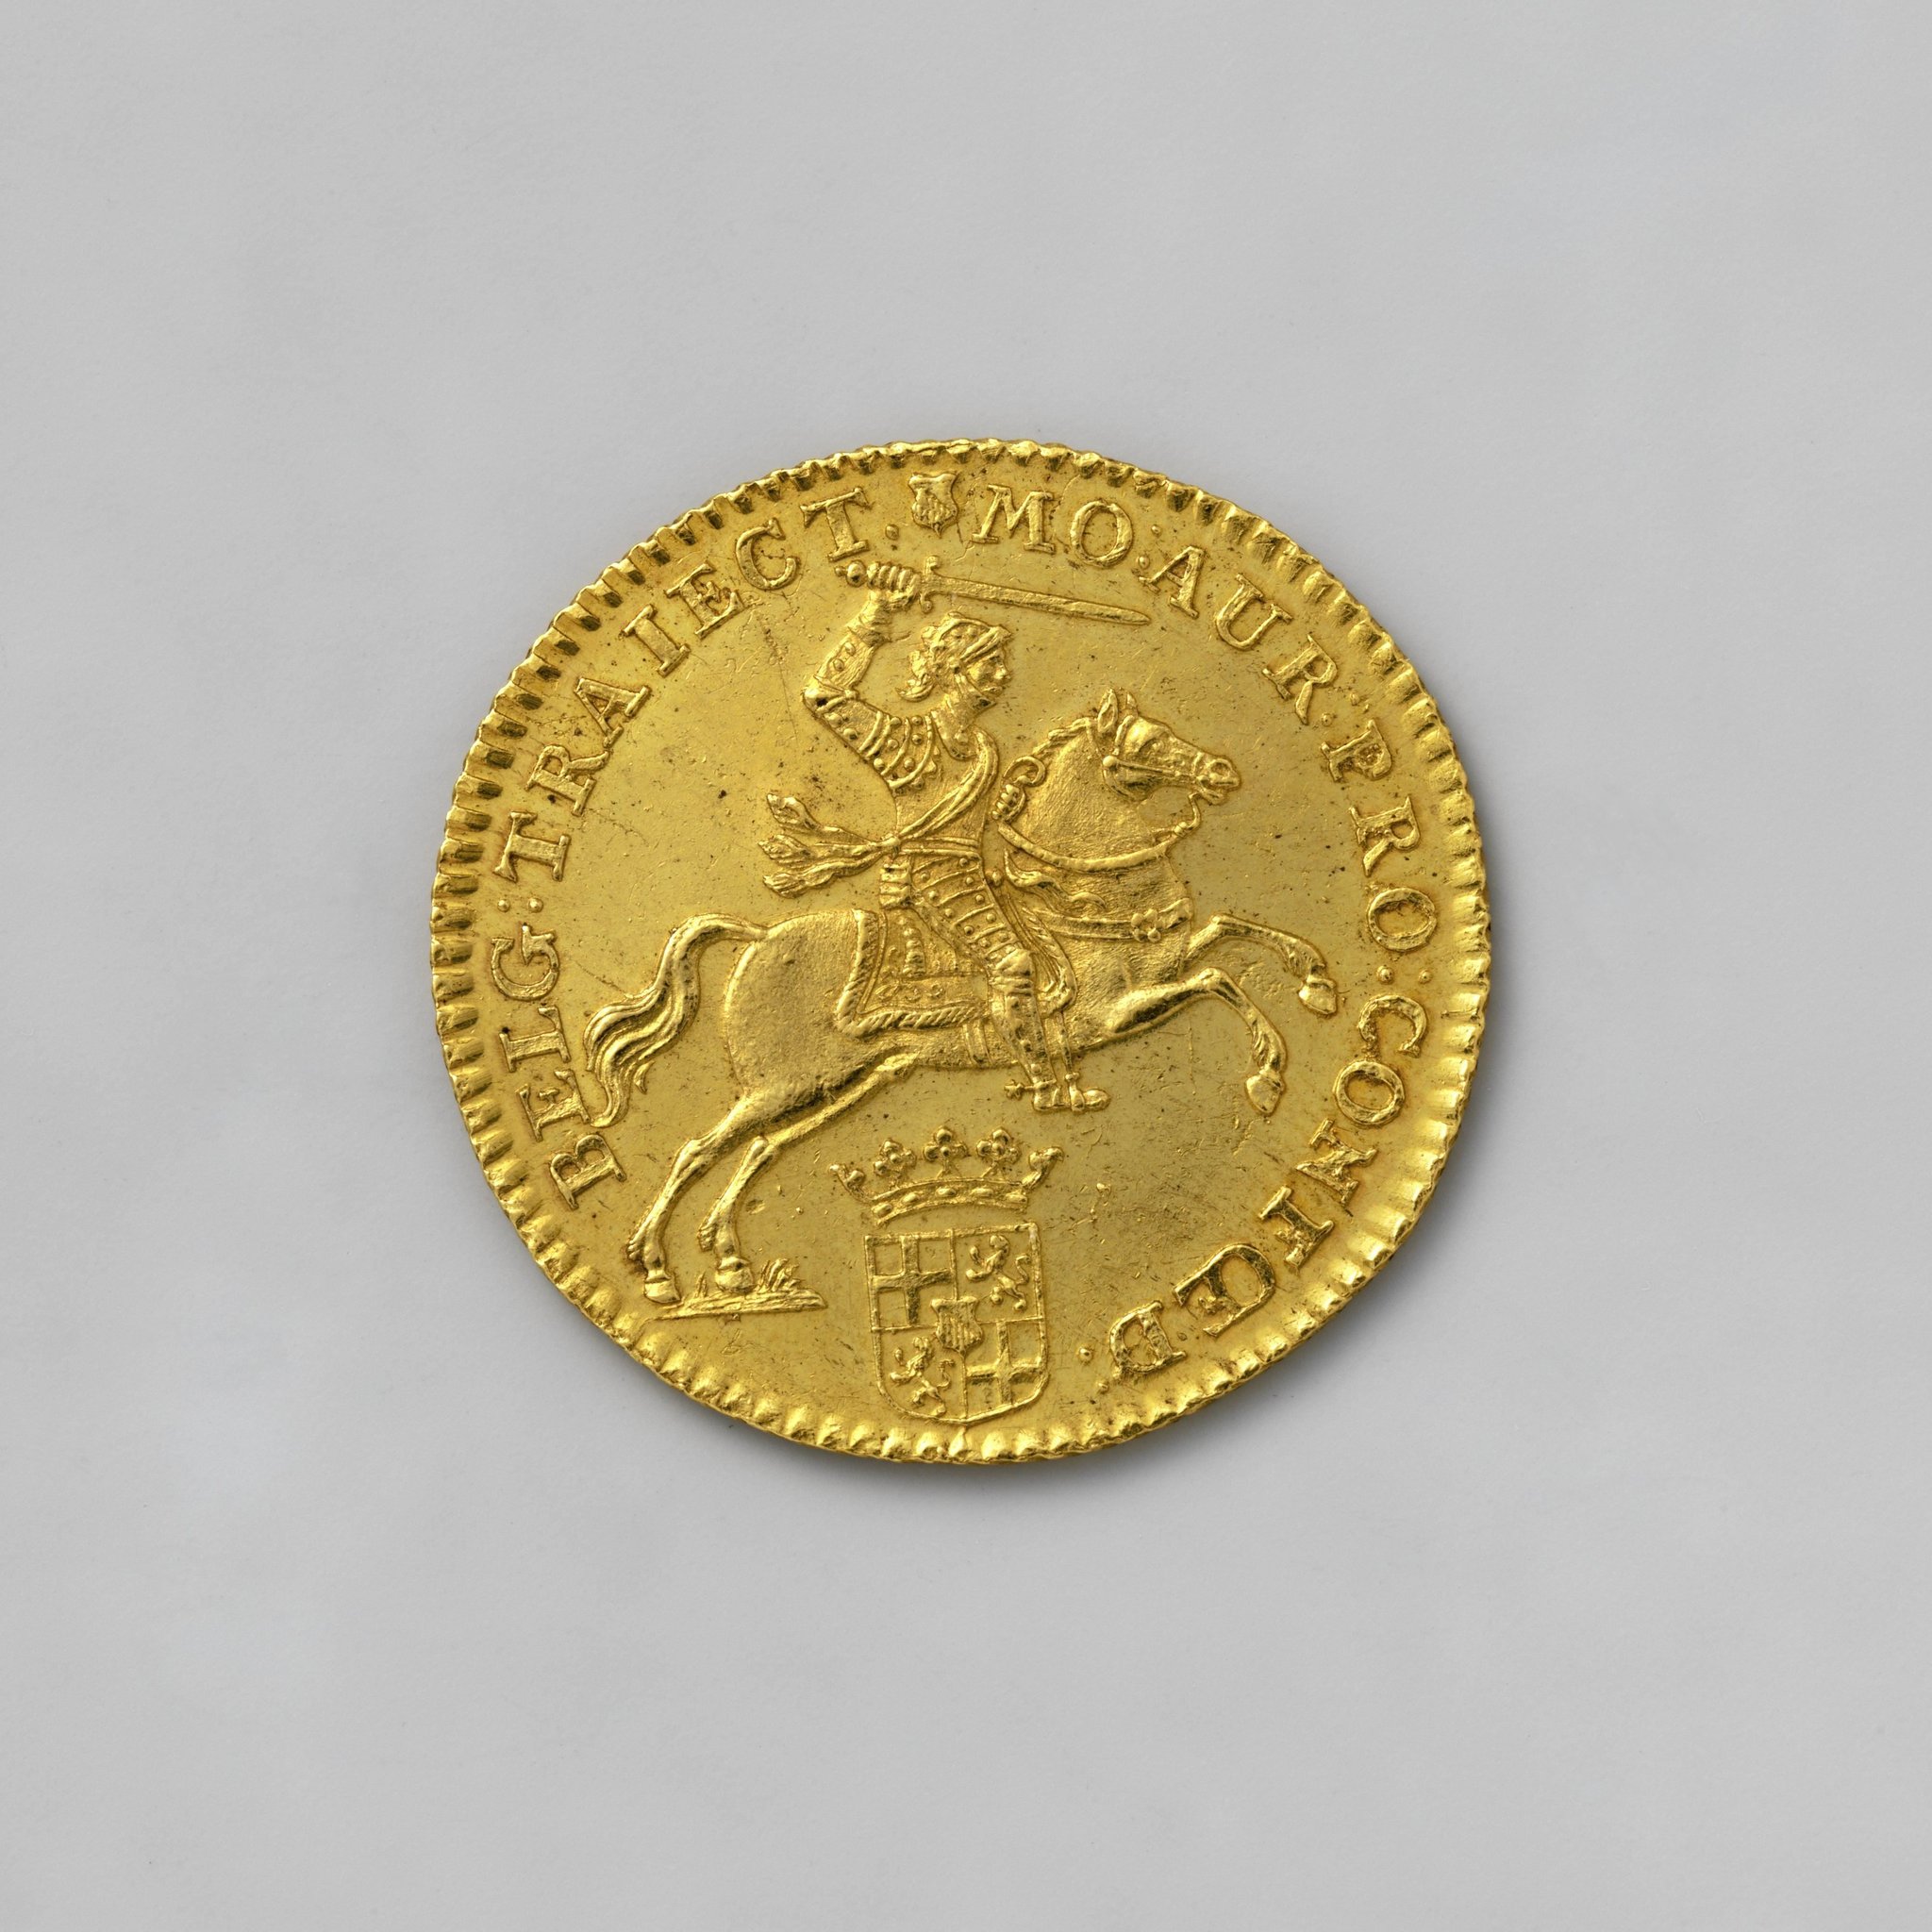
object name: gouden rijder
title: Utrecht, gouden rijder, 1760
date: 1760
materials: gold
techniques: striking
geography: utrecht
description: Voorzijde: ruiter met zwaard naar rechts, daaronder gekroond Utrechts wapenschild. Keerzijde: tussen waarde-aanduiding gekroond generaliteitswapenschild. Boven kroon jaartal. Kabelrand.